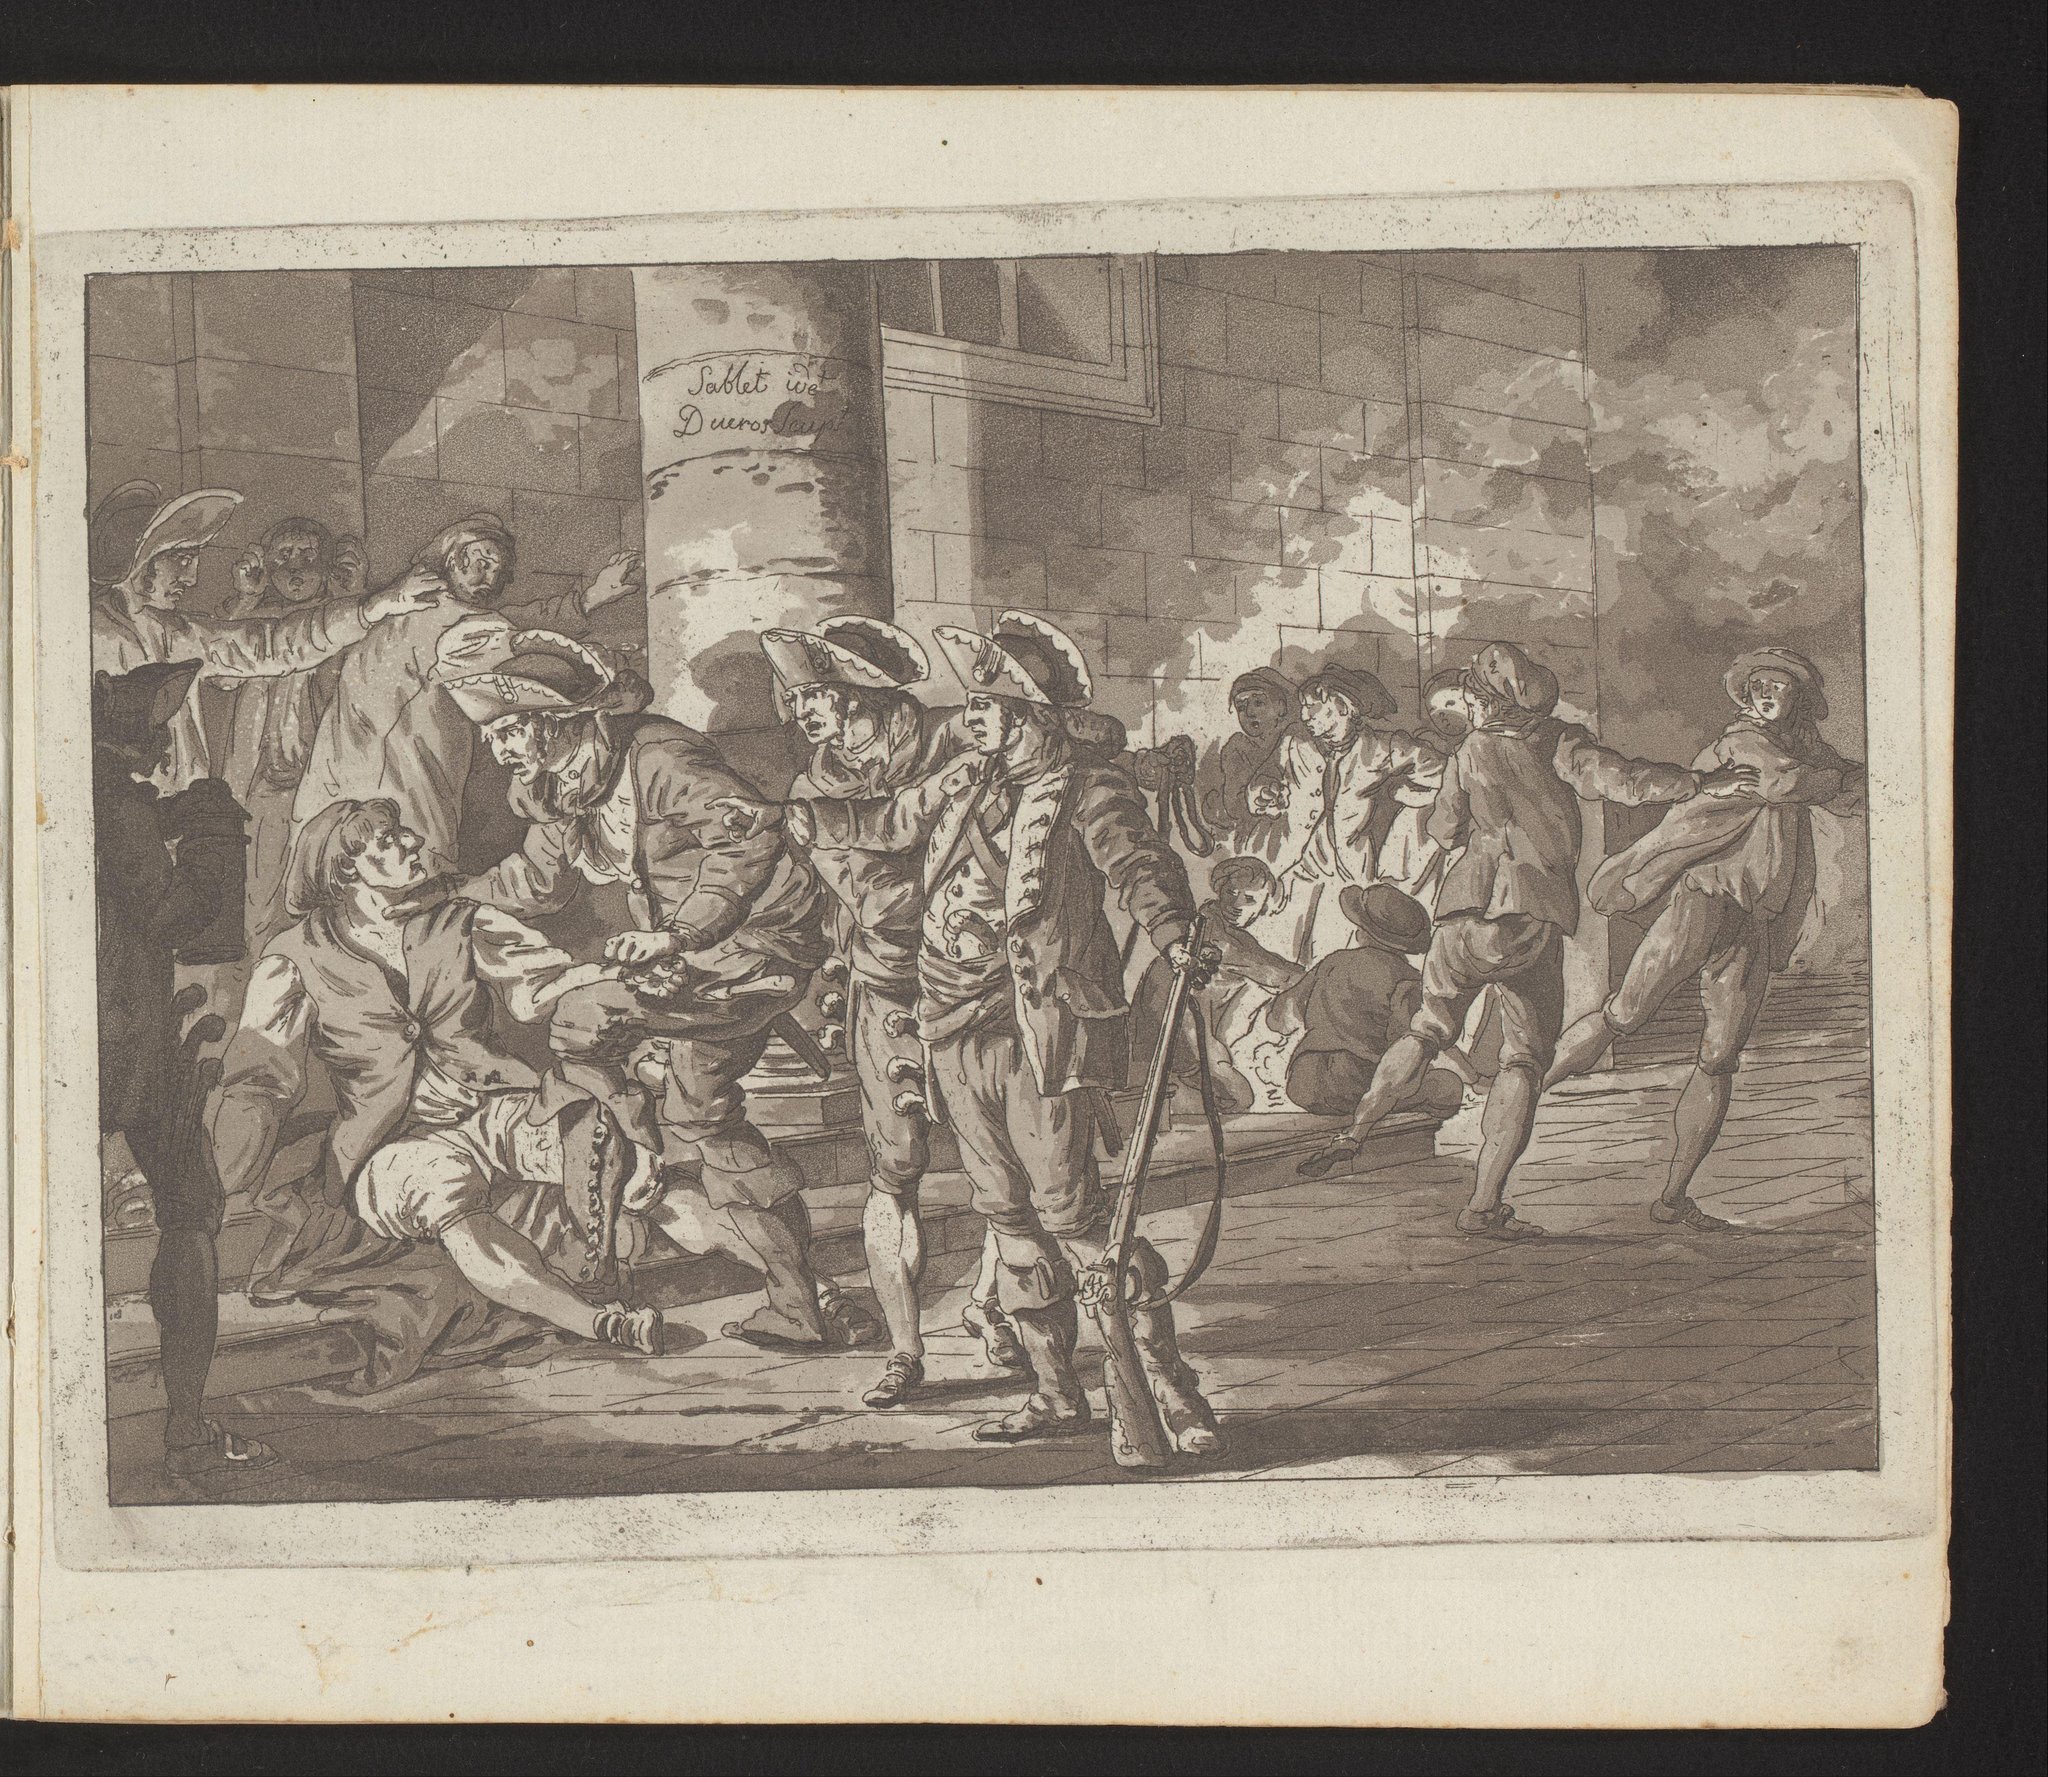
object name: album leaf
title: Man op straat wordt opgepakt door soldaten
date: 1758-1810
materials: paper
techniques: aquatint, etching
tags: flight, running away; pursuing, arrest ~ military service, europeans (with name)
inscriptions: collector's mark: Lugt 2228, collector's mark: Lugt 2760